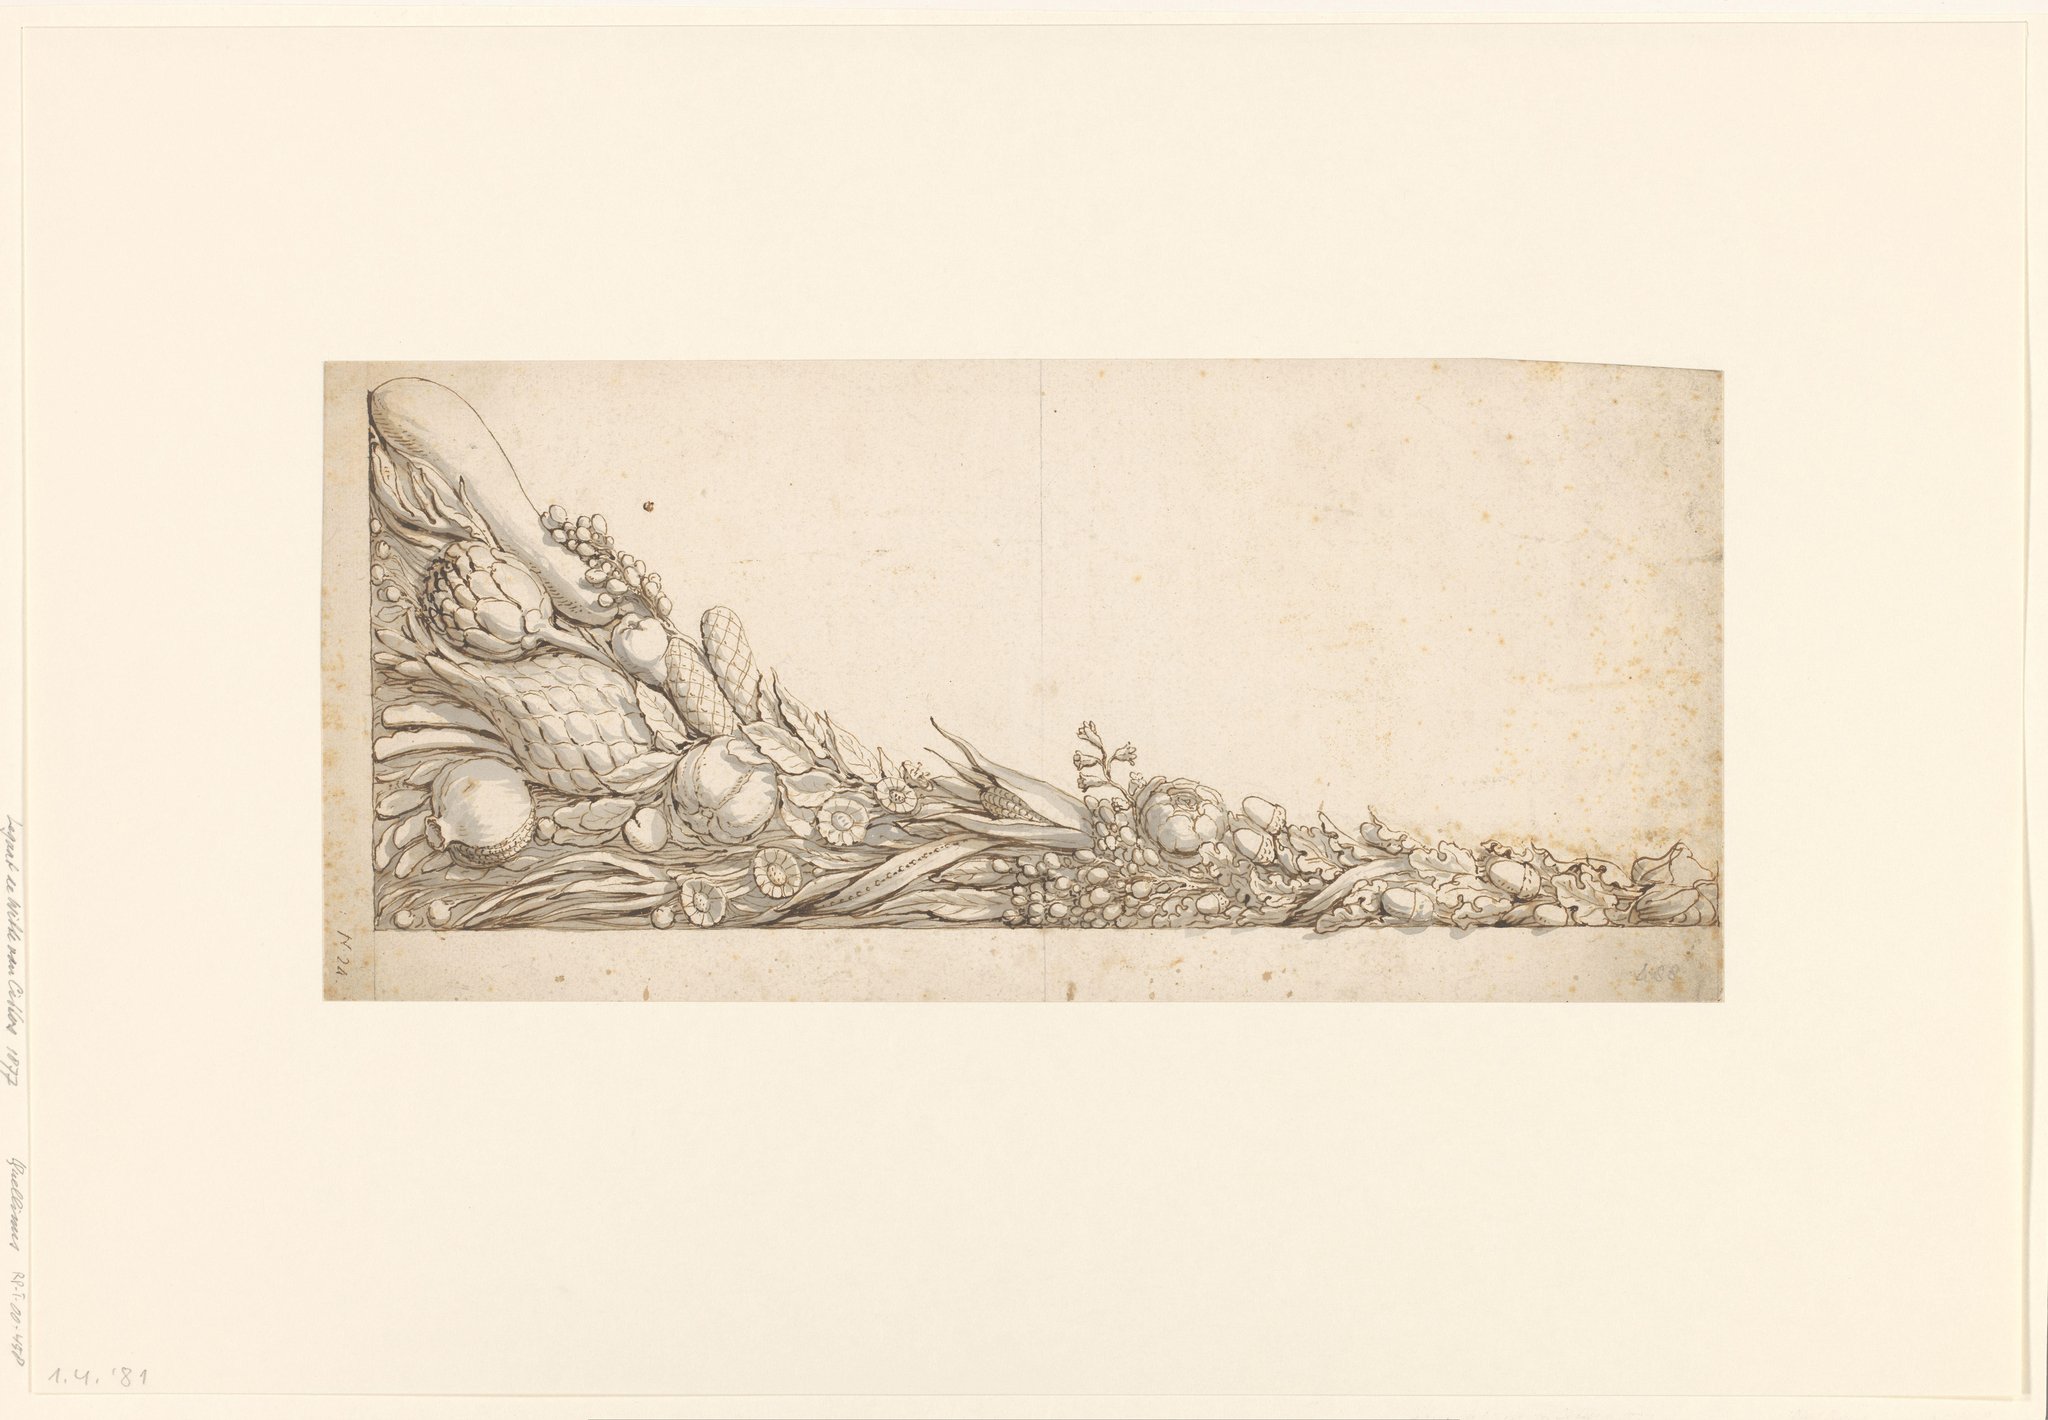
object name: drawing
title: Ornament van vruchten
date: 1619-1668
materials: ink, paper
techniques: brush, pen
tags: fruits and vegetables ~ ornament